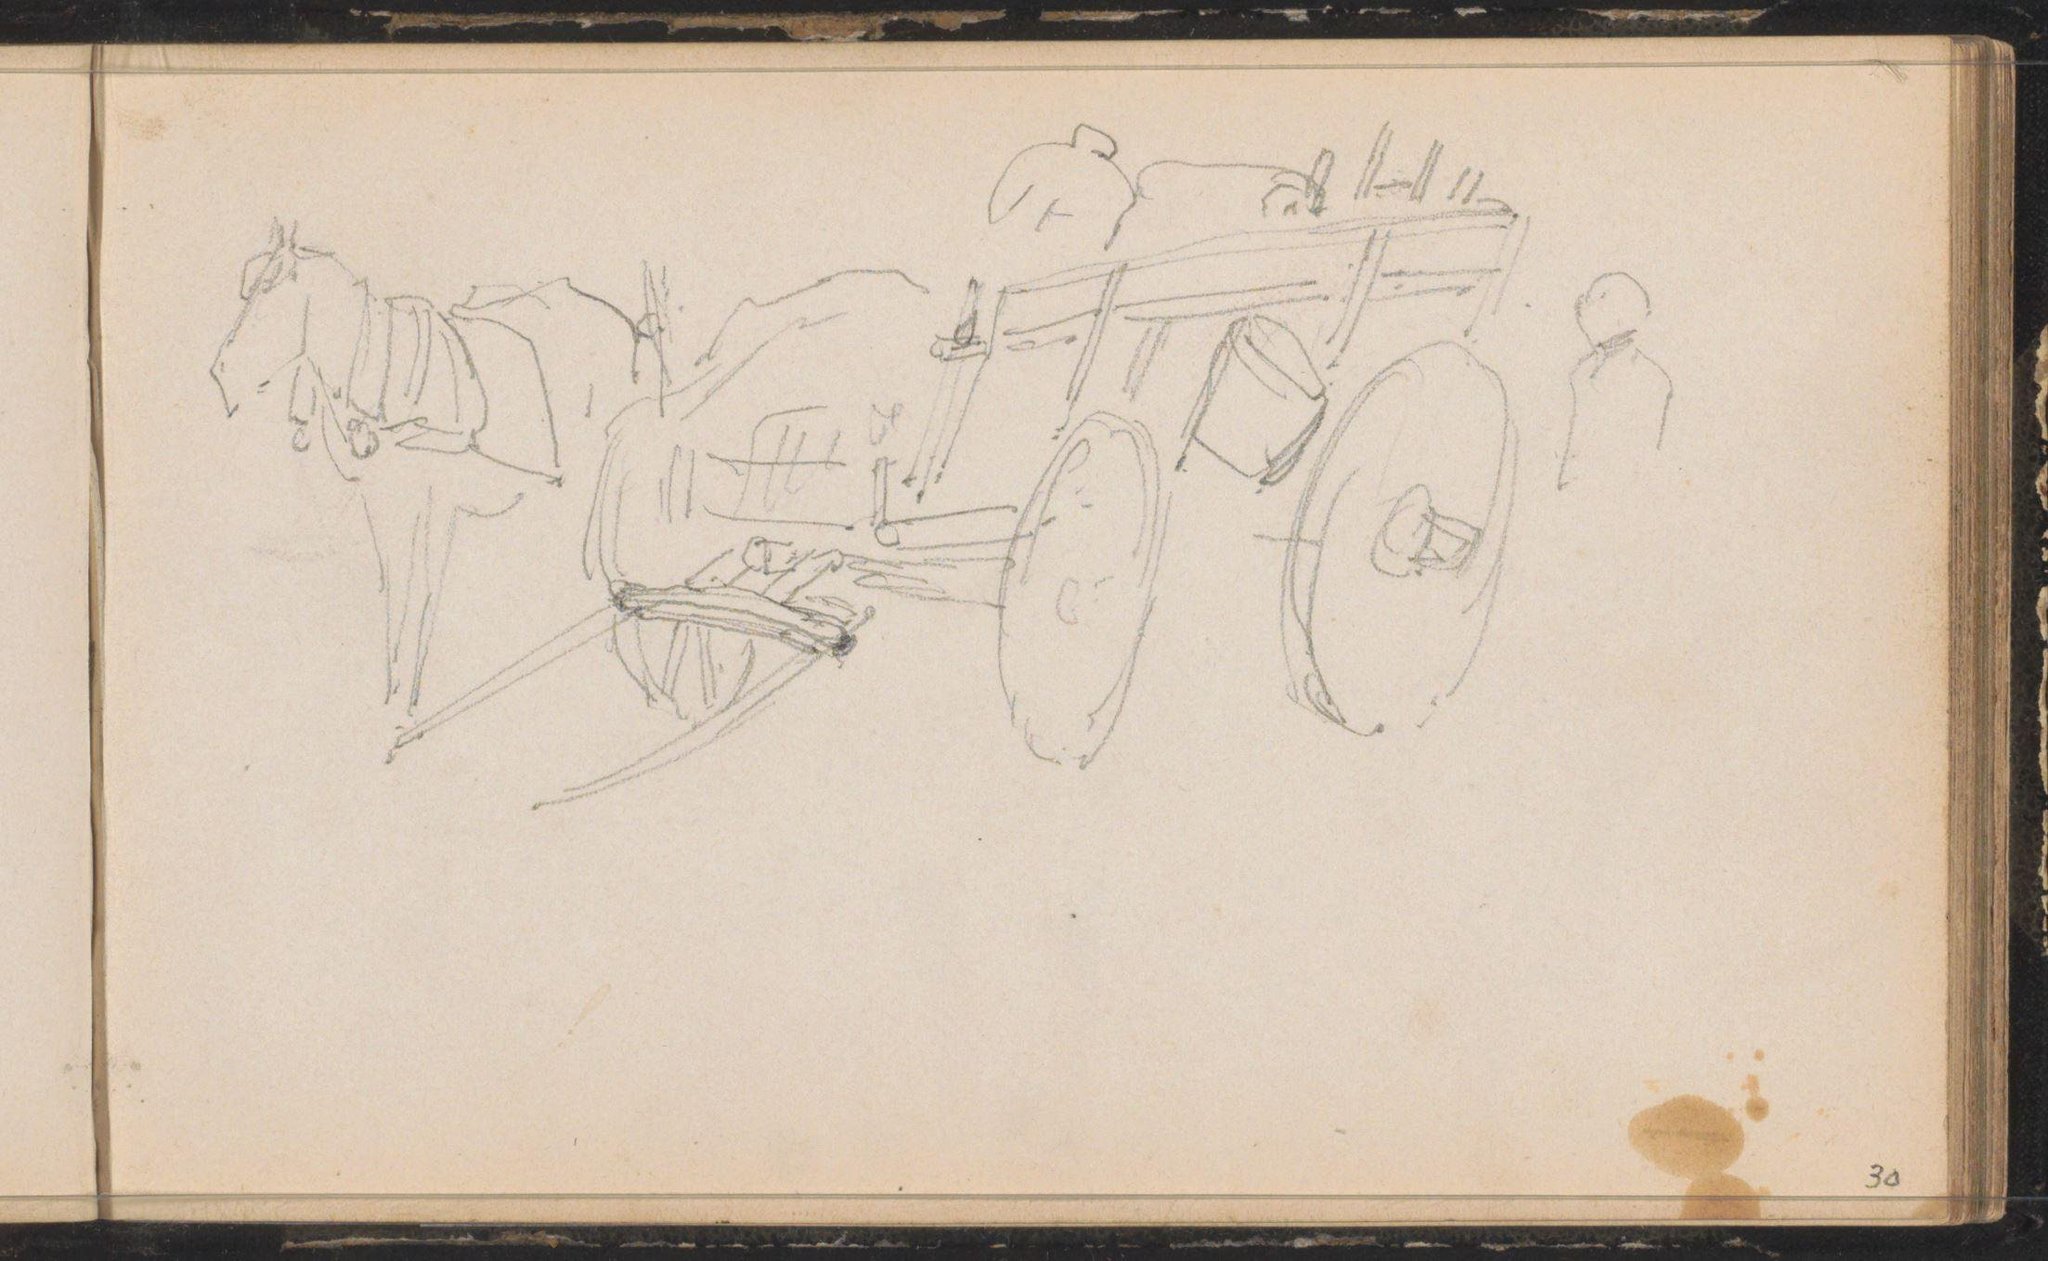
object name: sketchbook leaf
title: Paard-en-wagen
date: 1863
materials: paper, pencil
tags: horse, (farm) wagon, freight wagon, cart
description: Wagen met een uitgespannen paard. Blad 30 uit een schetsboek met 55 bladen vervaardigd op de Veluwe en in Noord-Duitsland.